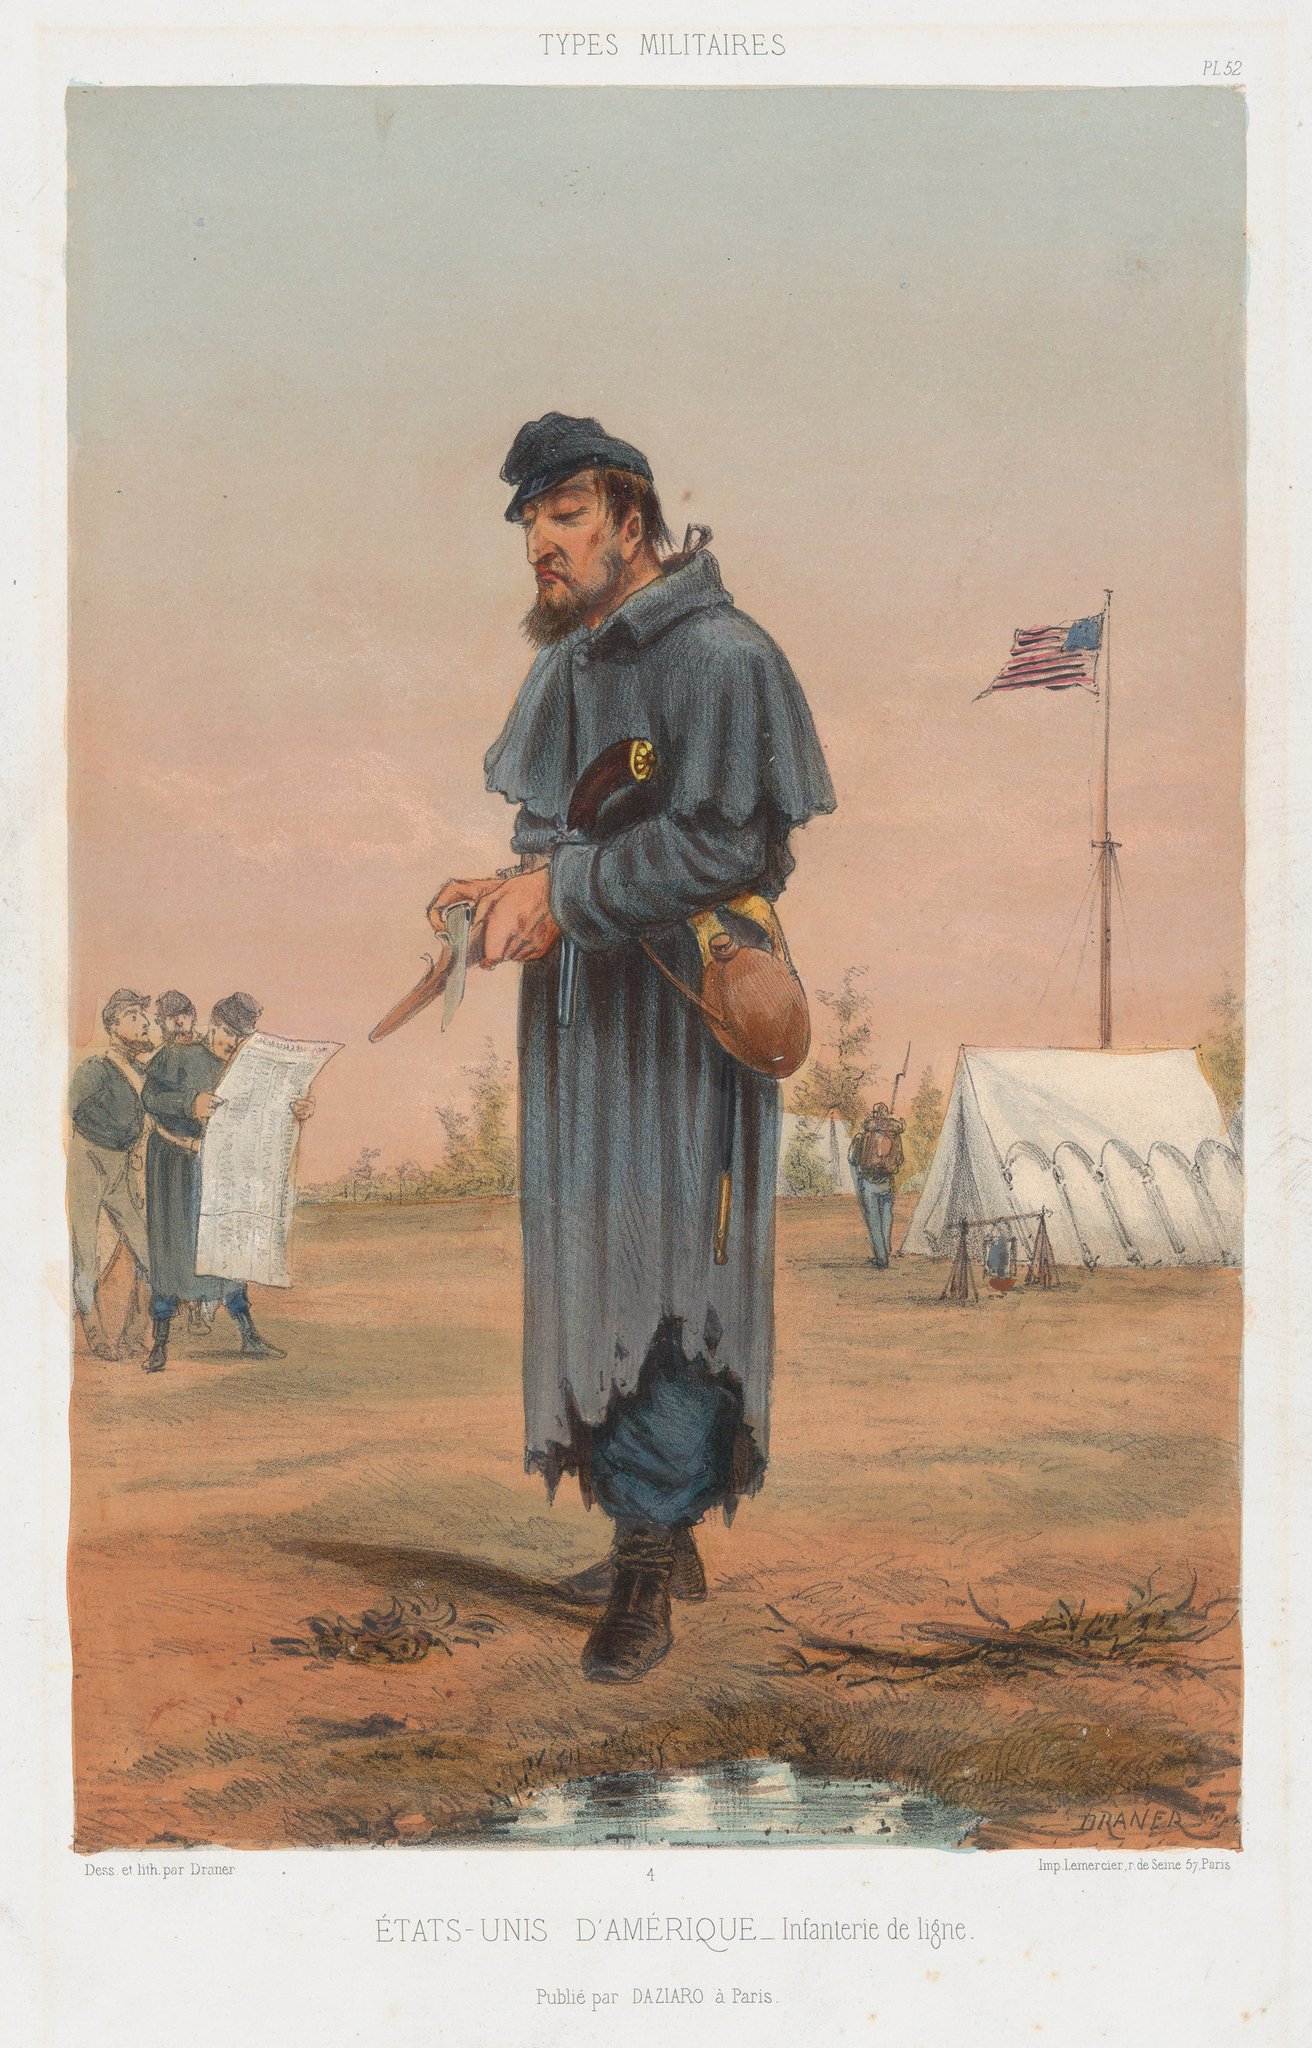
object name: print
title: États-Unis d'Amerique - Infanterie de ligne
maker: draner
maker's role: artist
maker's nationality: french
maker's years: 1800-1900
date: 1865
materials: stone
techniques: hand coloring, lithograph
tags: tents,soldiers,american civil war,men,reading